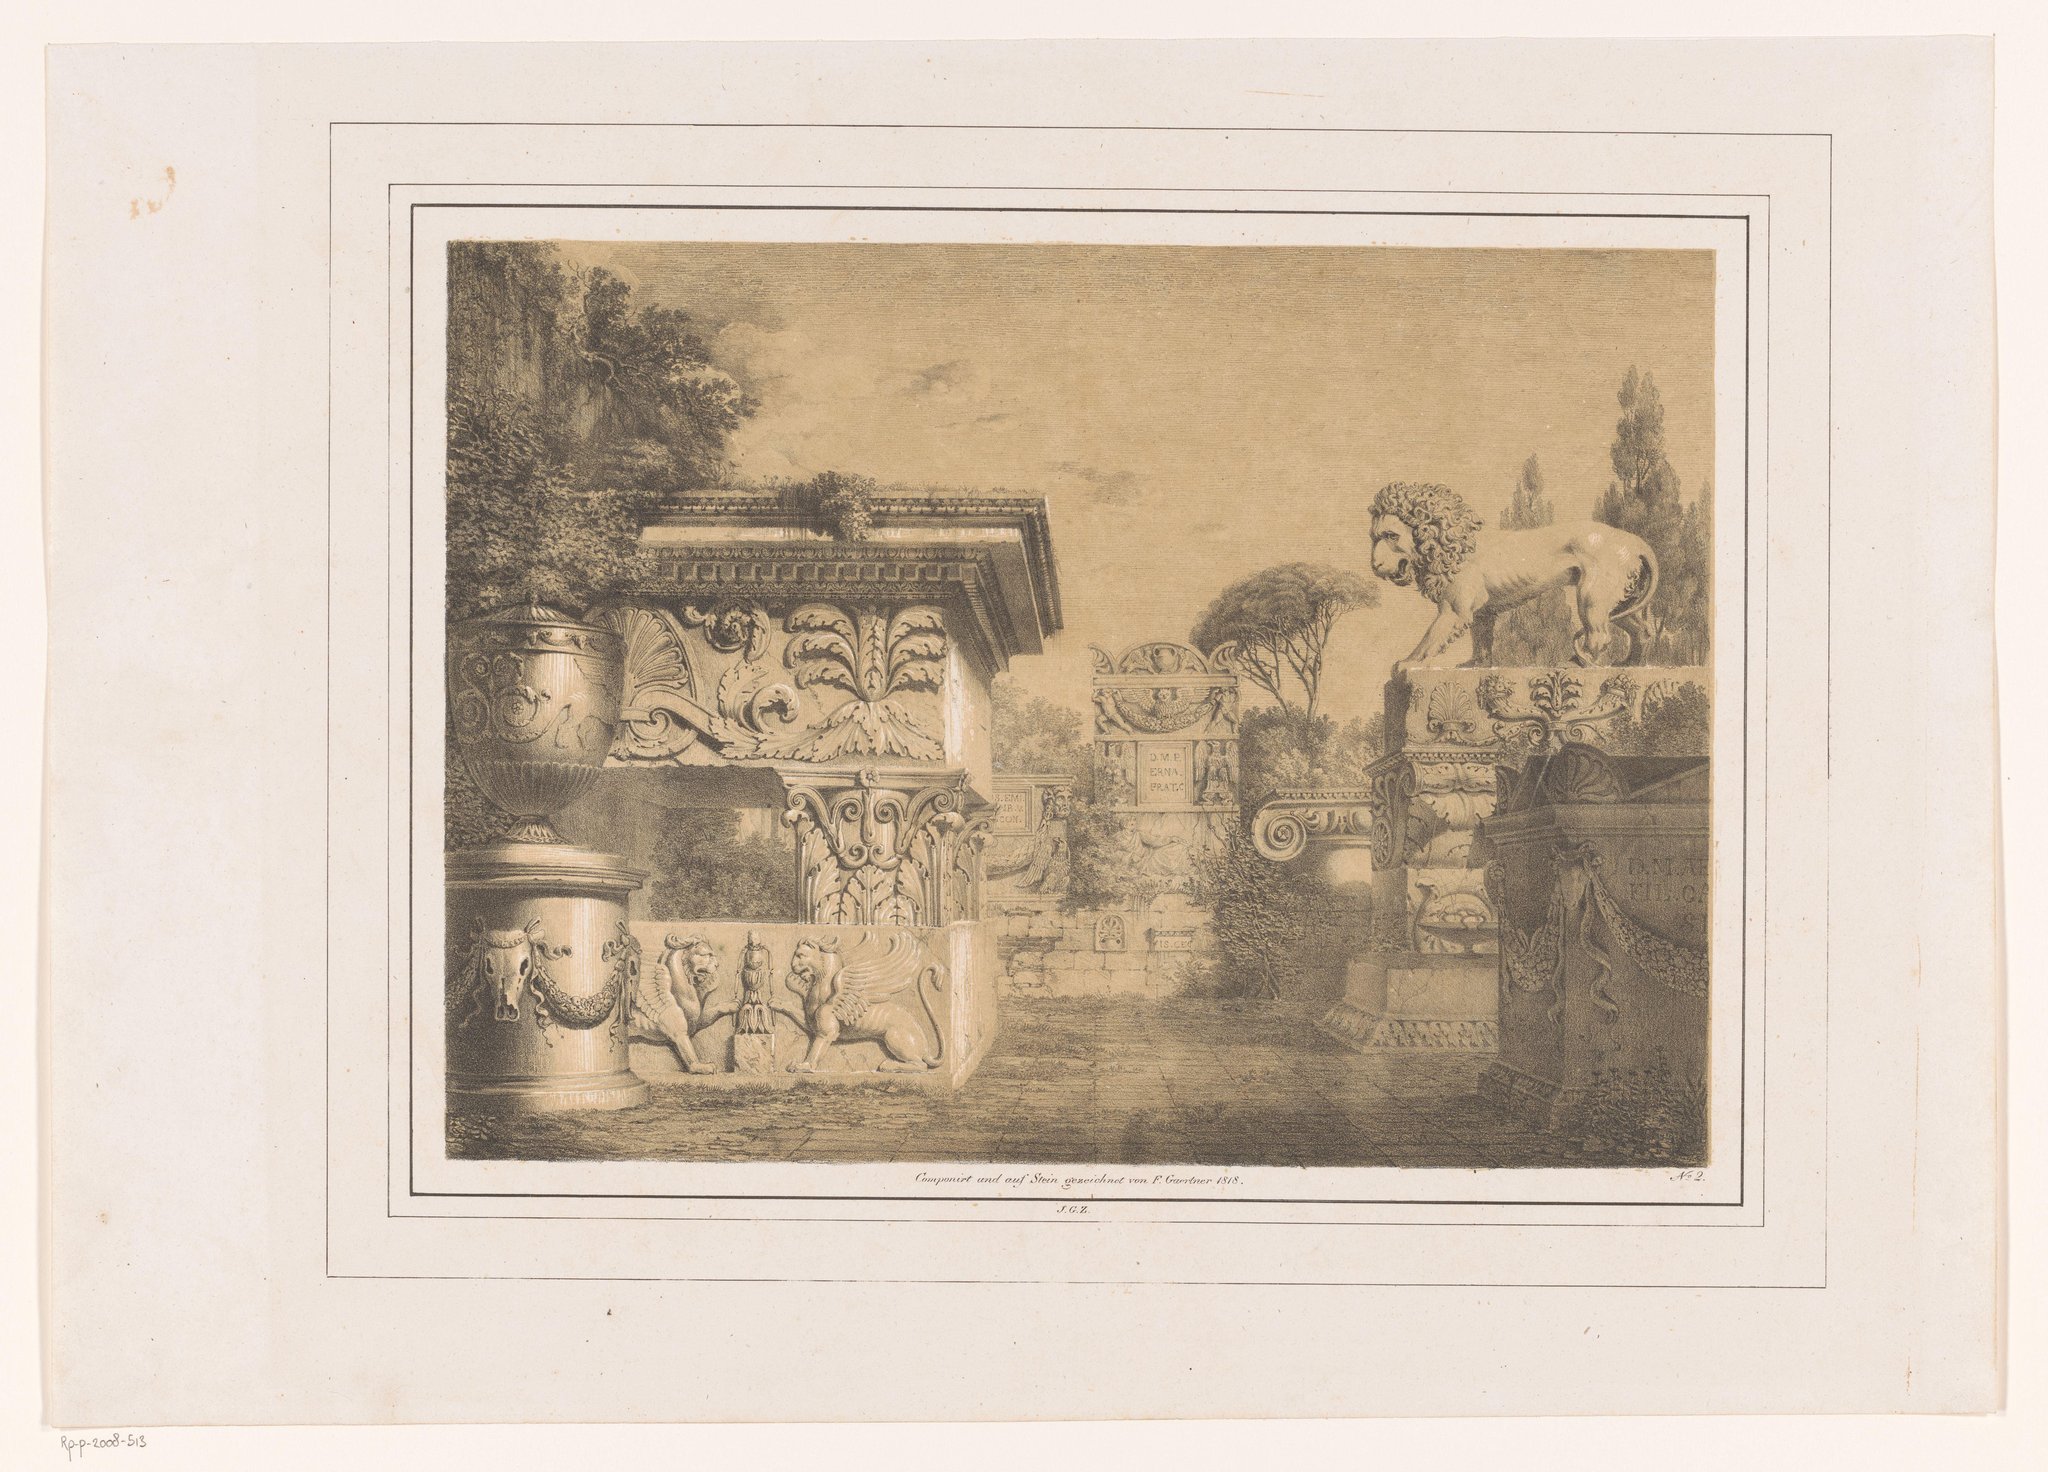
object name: print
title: Architectuurfantasie met antieke elementen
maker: friedrich von gärtner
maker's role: architect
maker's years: 1792-1847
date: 1818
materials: paper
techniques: tone lithography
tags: fantastic architecture, unrealistic architectural fantasies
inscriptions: collector's mark: Lugt 2228, collector's mark: Lugt 2760